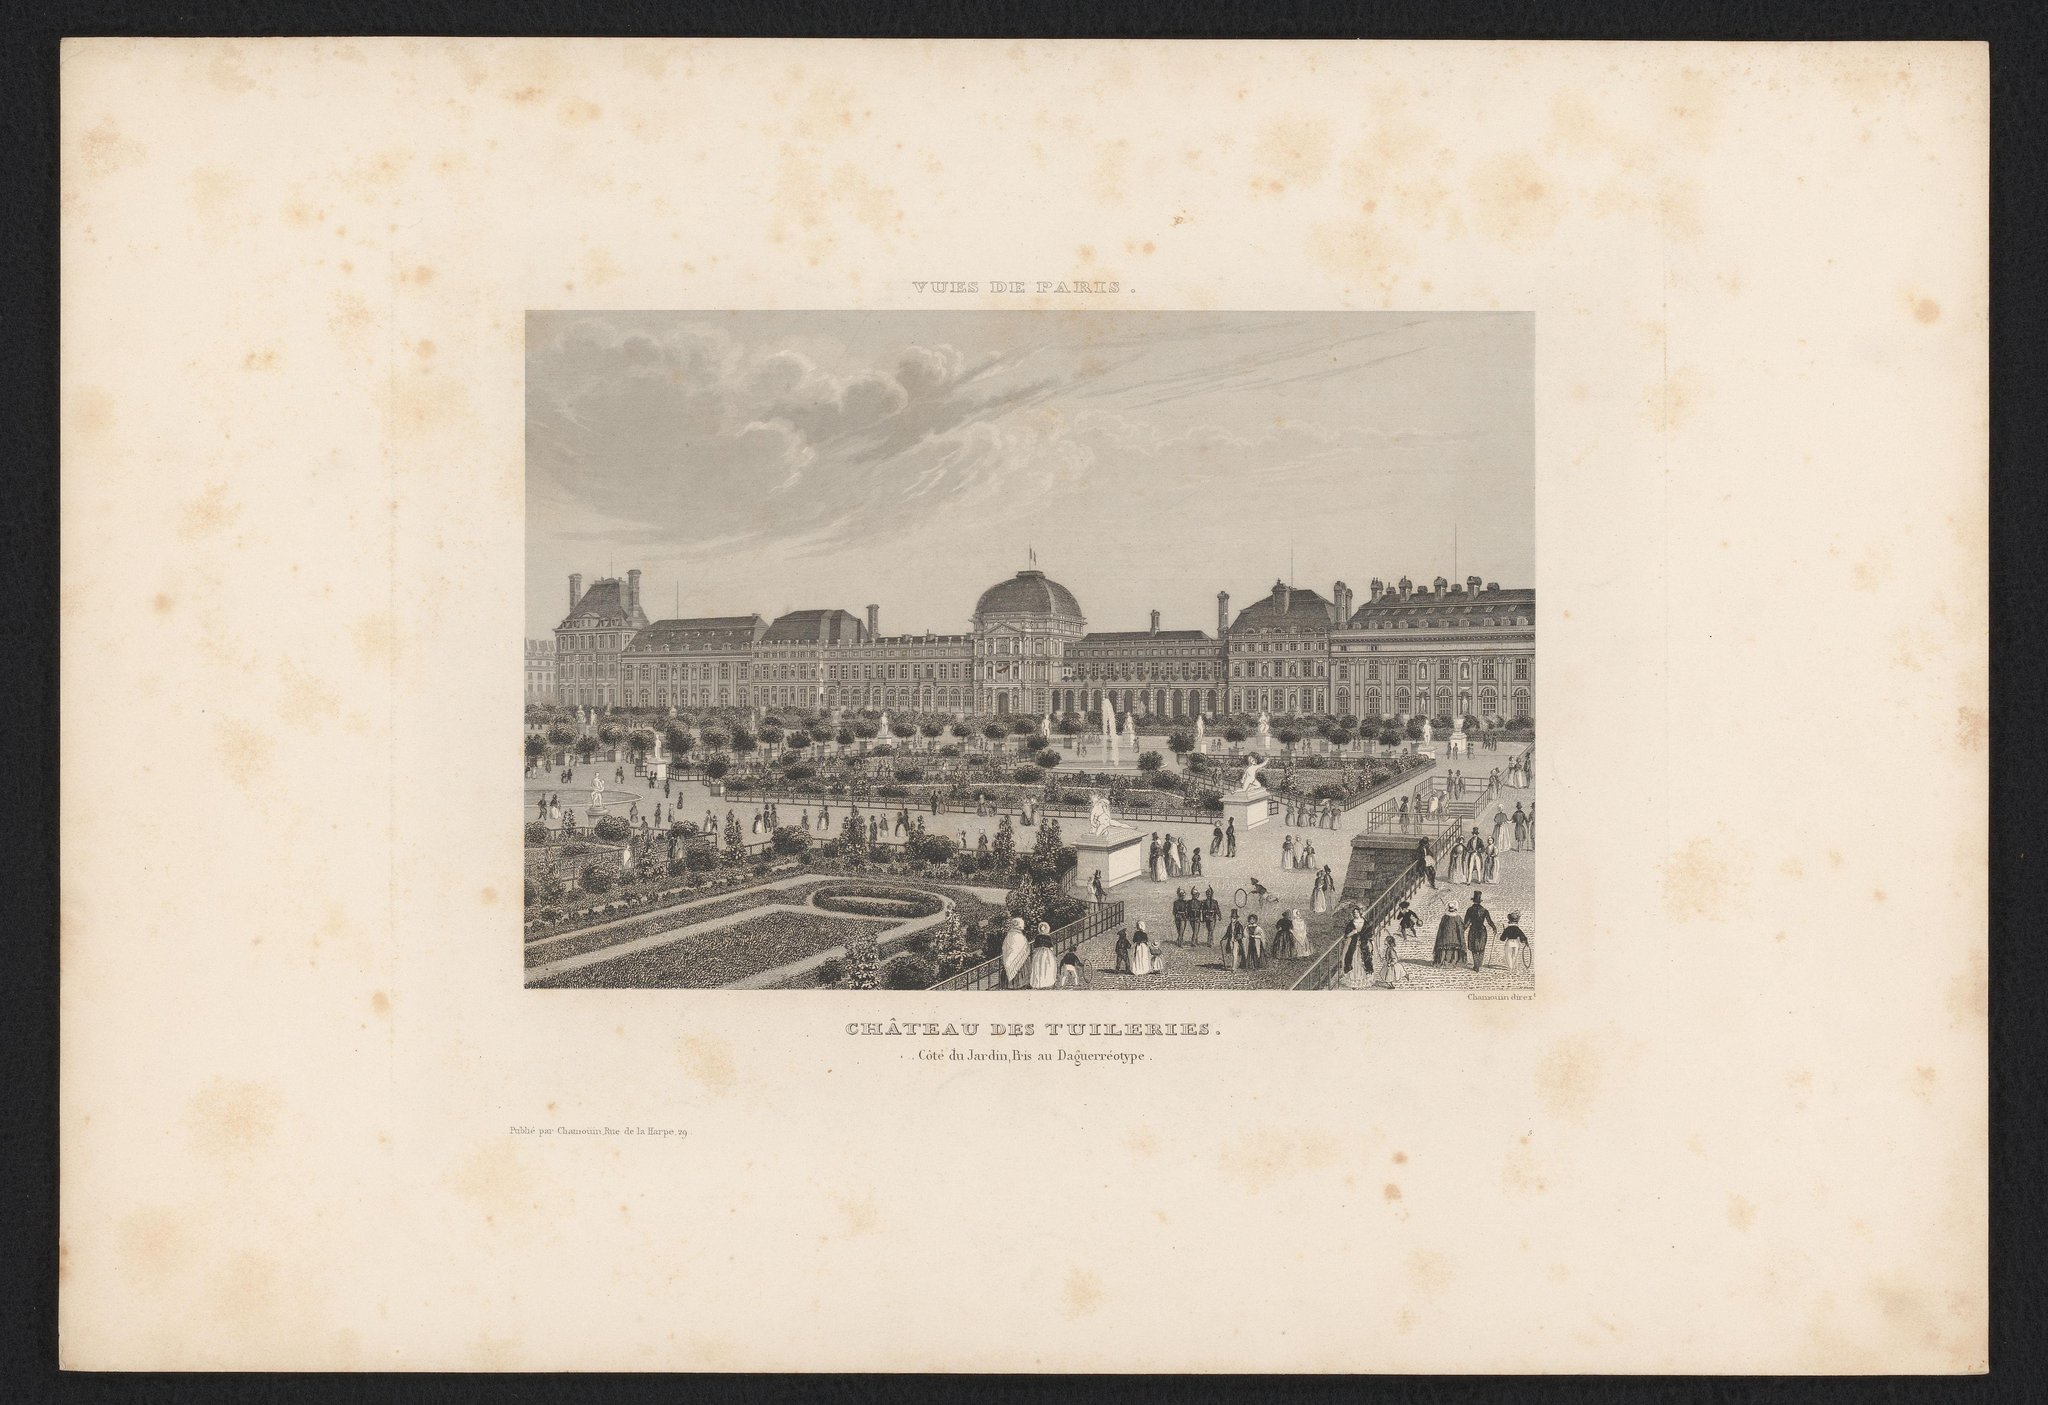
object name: print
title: Gezicht op het Tuilerieënpaleis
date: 1845-1850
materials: paper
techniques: engraving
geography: paris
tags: palace, tuileries palace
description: Deze prent maakt deel uit van een omslag met 22 prenten op 22 bladen.